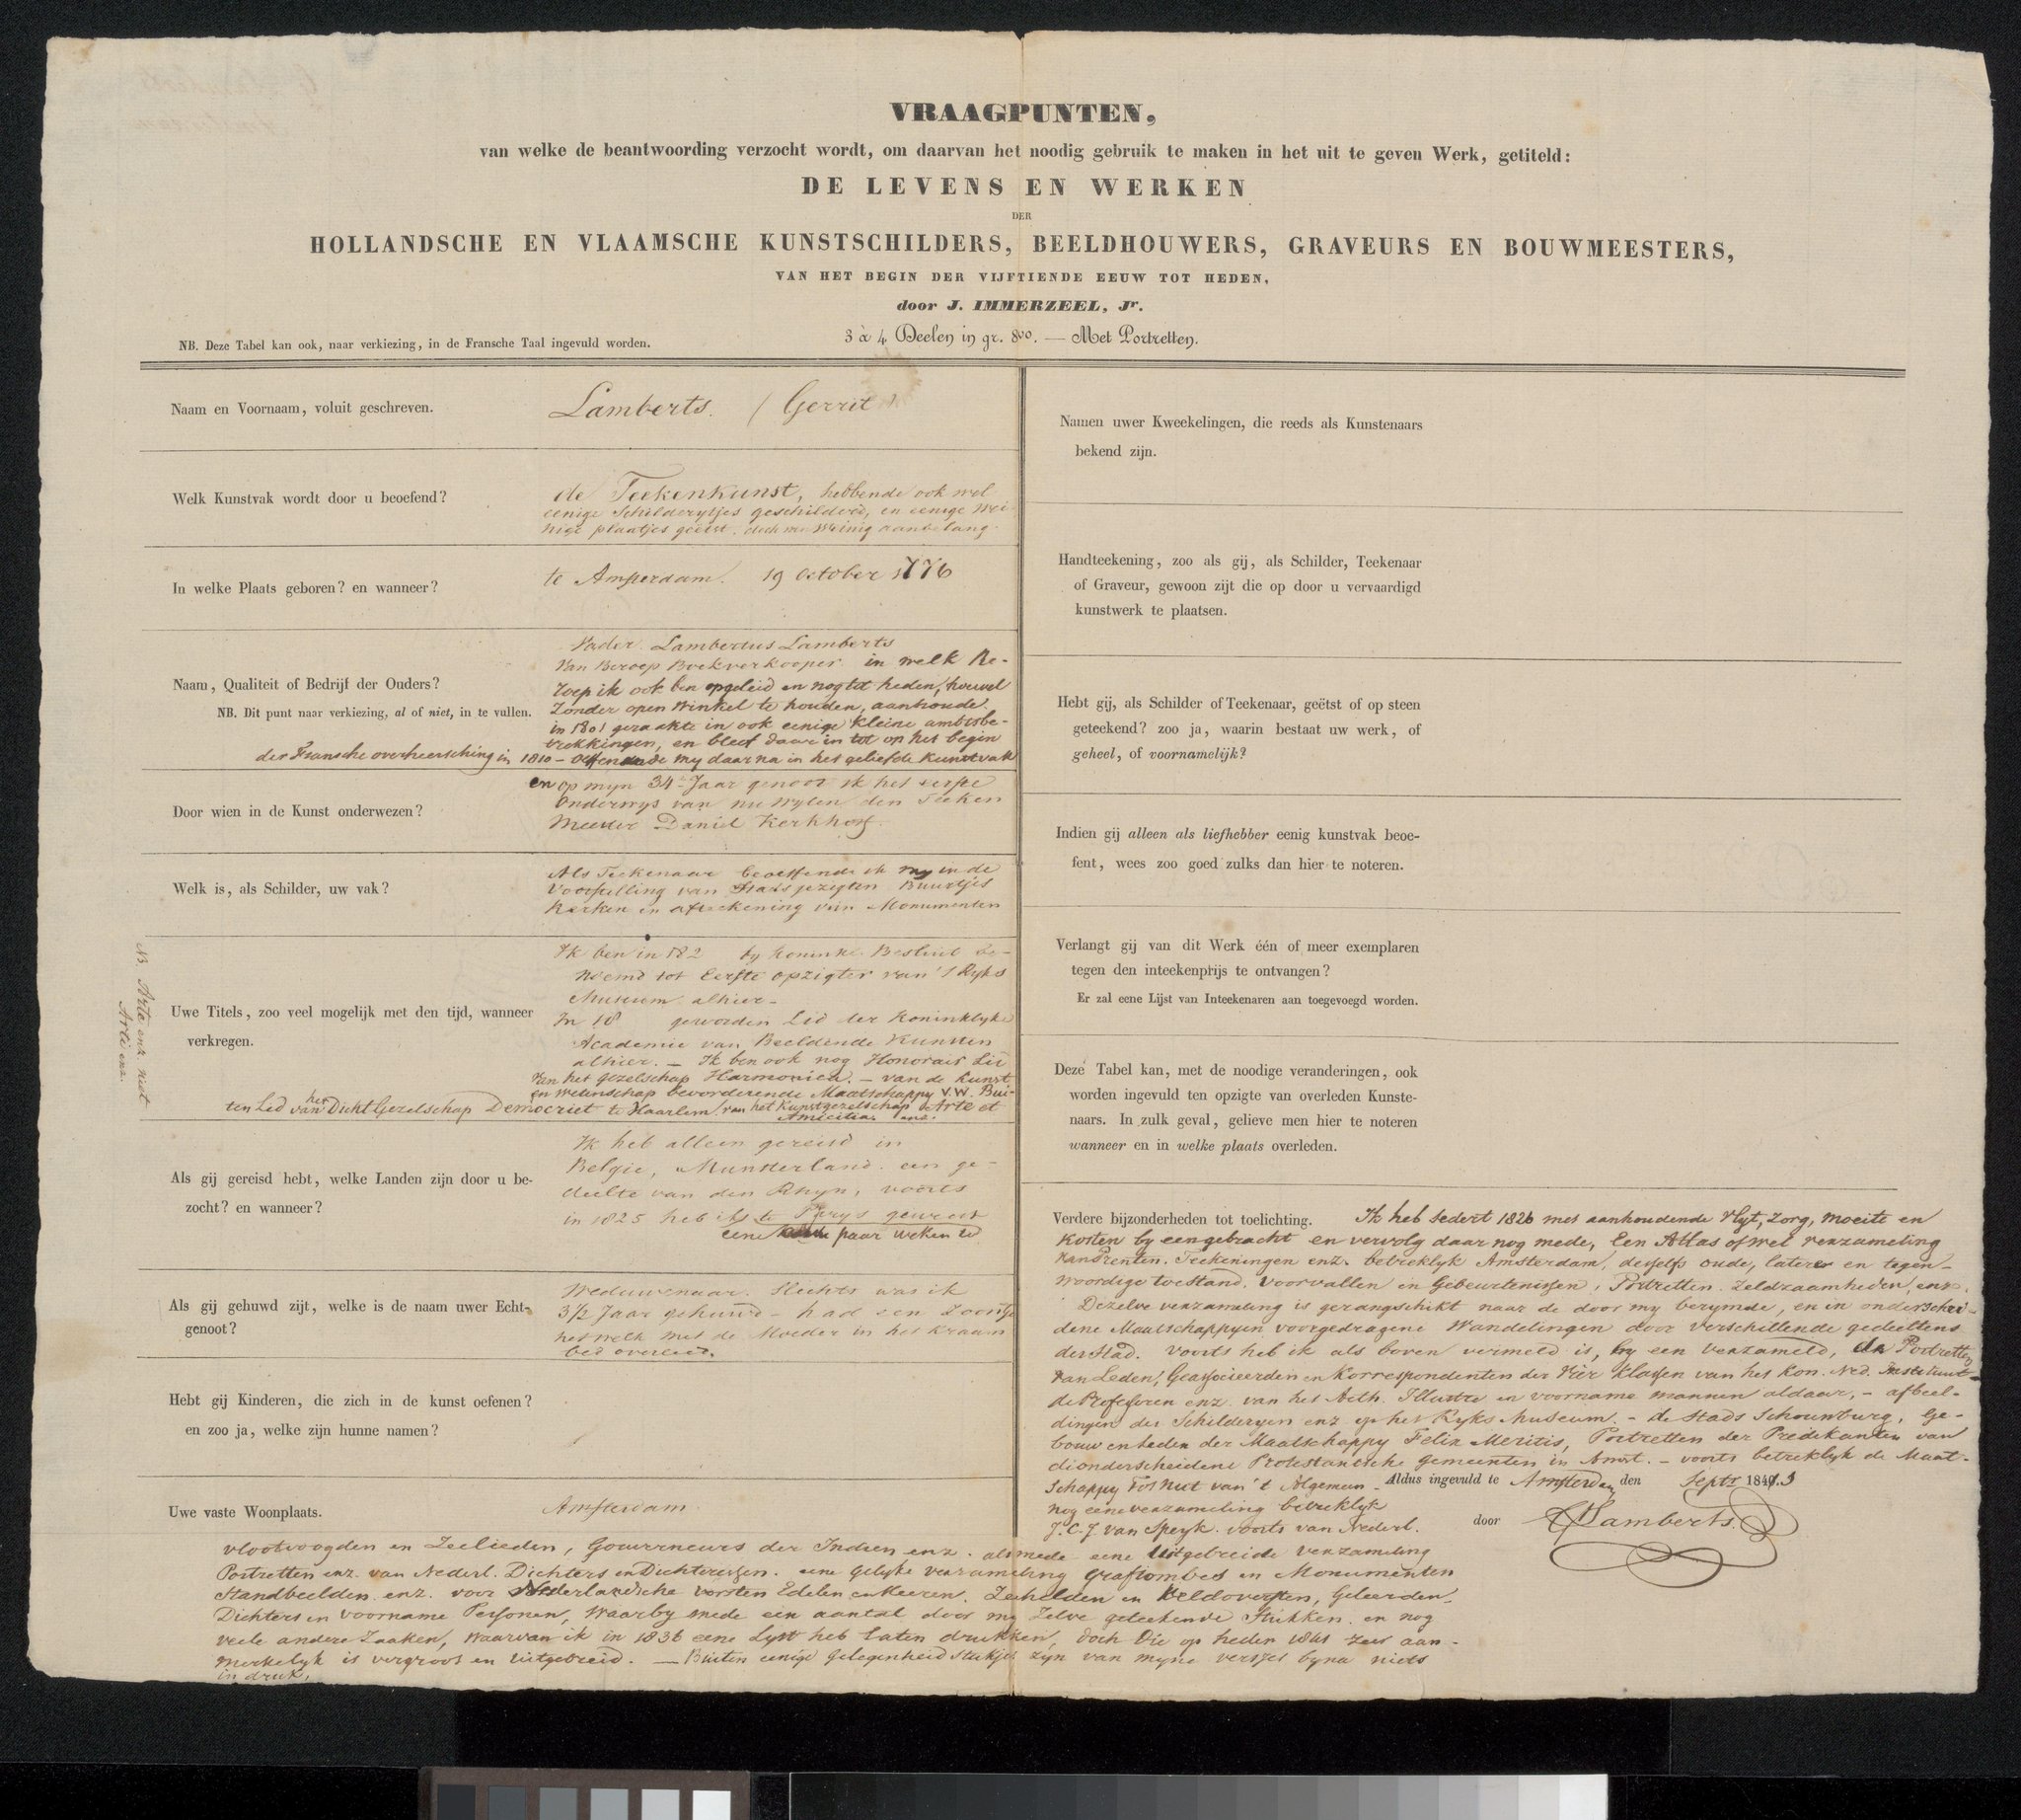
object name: manuscript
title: Enquêteformulier ingevuld door Gerrit Lamberts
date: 1809-1843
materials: ink, paper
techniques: pen, printing, writing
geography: amsterdam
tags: amsterdam, print maker, draughtsman, bookseller, gerrit lamberts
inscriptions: watermark, inscription: ‘Vraagpunten,/ van welke de beantwoording verzocht wordt, om daarvan het noodig gebruik te maken in het uit te geven Werk, getiteld: De levens en werken/ der Hollandsche en Vlaamsche kunstschilders, beeldhouwers,/ graveurs en bouwmeesters, van het begin der vijftiende eeuw tot heden/ door J. Immerzeel, Jr.’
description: Opgenomen in: Immerzeel, J. Jr., De levens en werken der Hollandsche en Vlaamsche kunstschilders, beeldhouwers, graveurs en bouwmeesters, van het begin der vijftiende eeuw tot heden, Amsterdam: J.C. van Kesteren, 1842-1843.